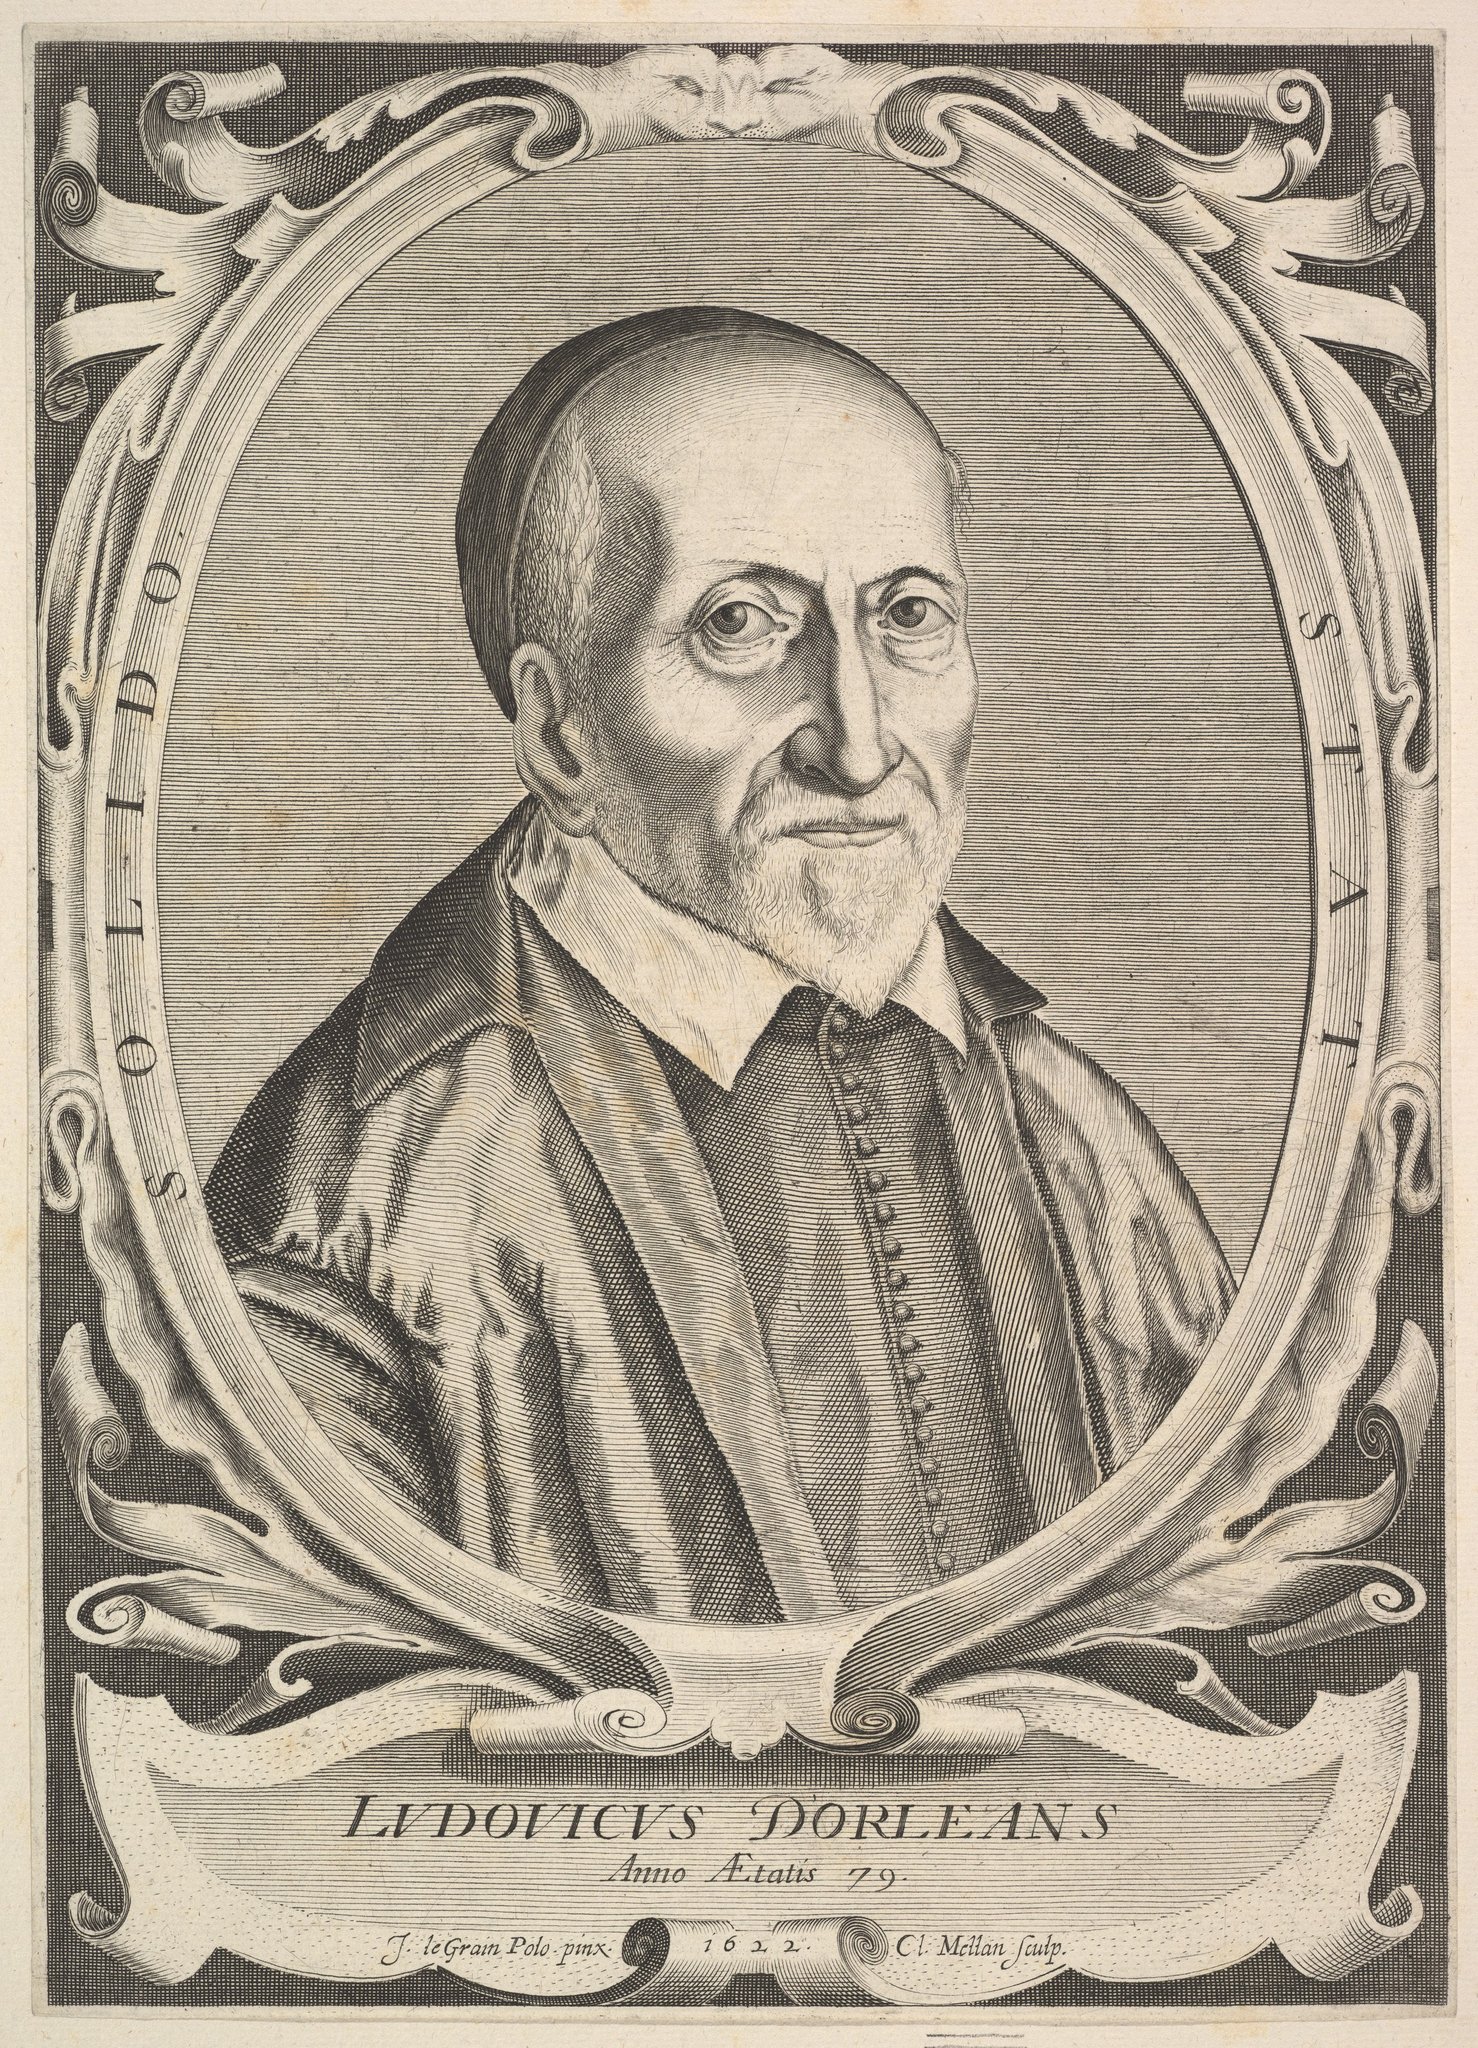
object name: print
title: Portrait of Louis d'Orléans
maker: claude mellan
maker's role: artist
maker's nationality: french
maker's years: 1598-1688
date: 1622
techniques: engraving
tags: men,portraits